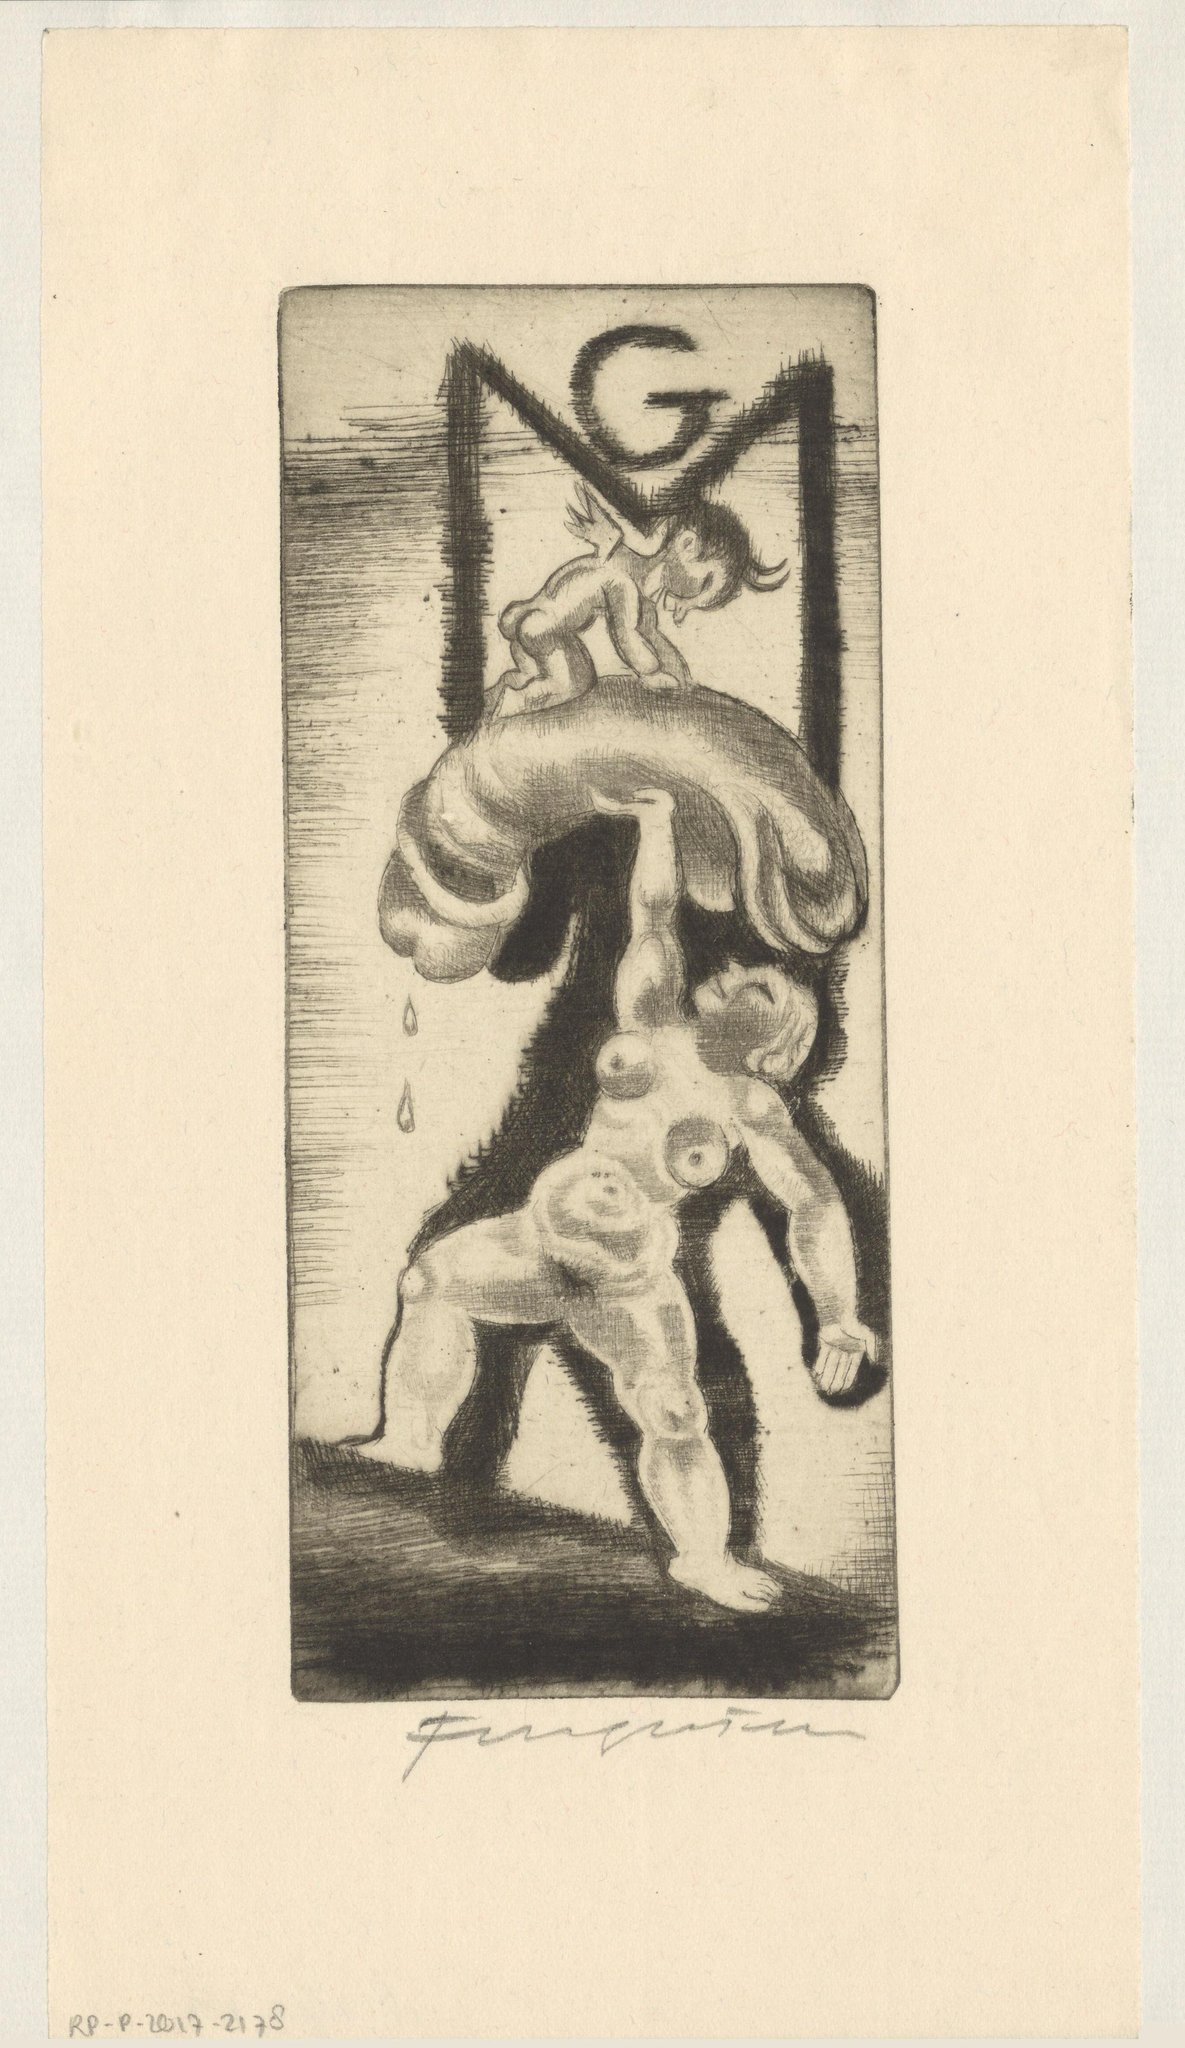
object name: photomechanical print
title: Ex libris van G.M.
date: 1930-1943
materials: paper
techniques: photograph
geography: milan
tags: engineer, gianni mantero, woman (showing herself) undressed, quasi-nude, penis, phallus, cupids: 'amores', 'amoretti', 'putti'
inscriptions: signature: ‘Fingesten’